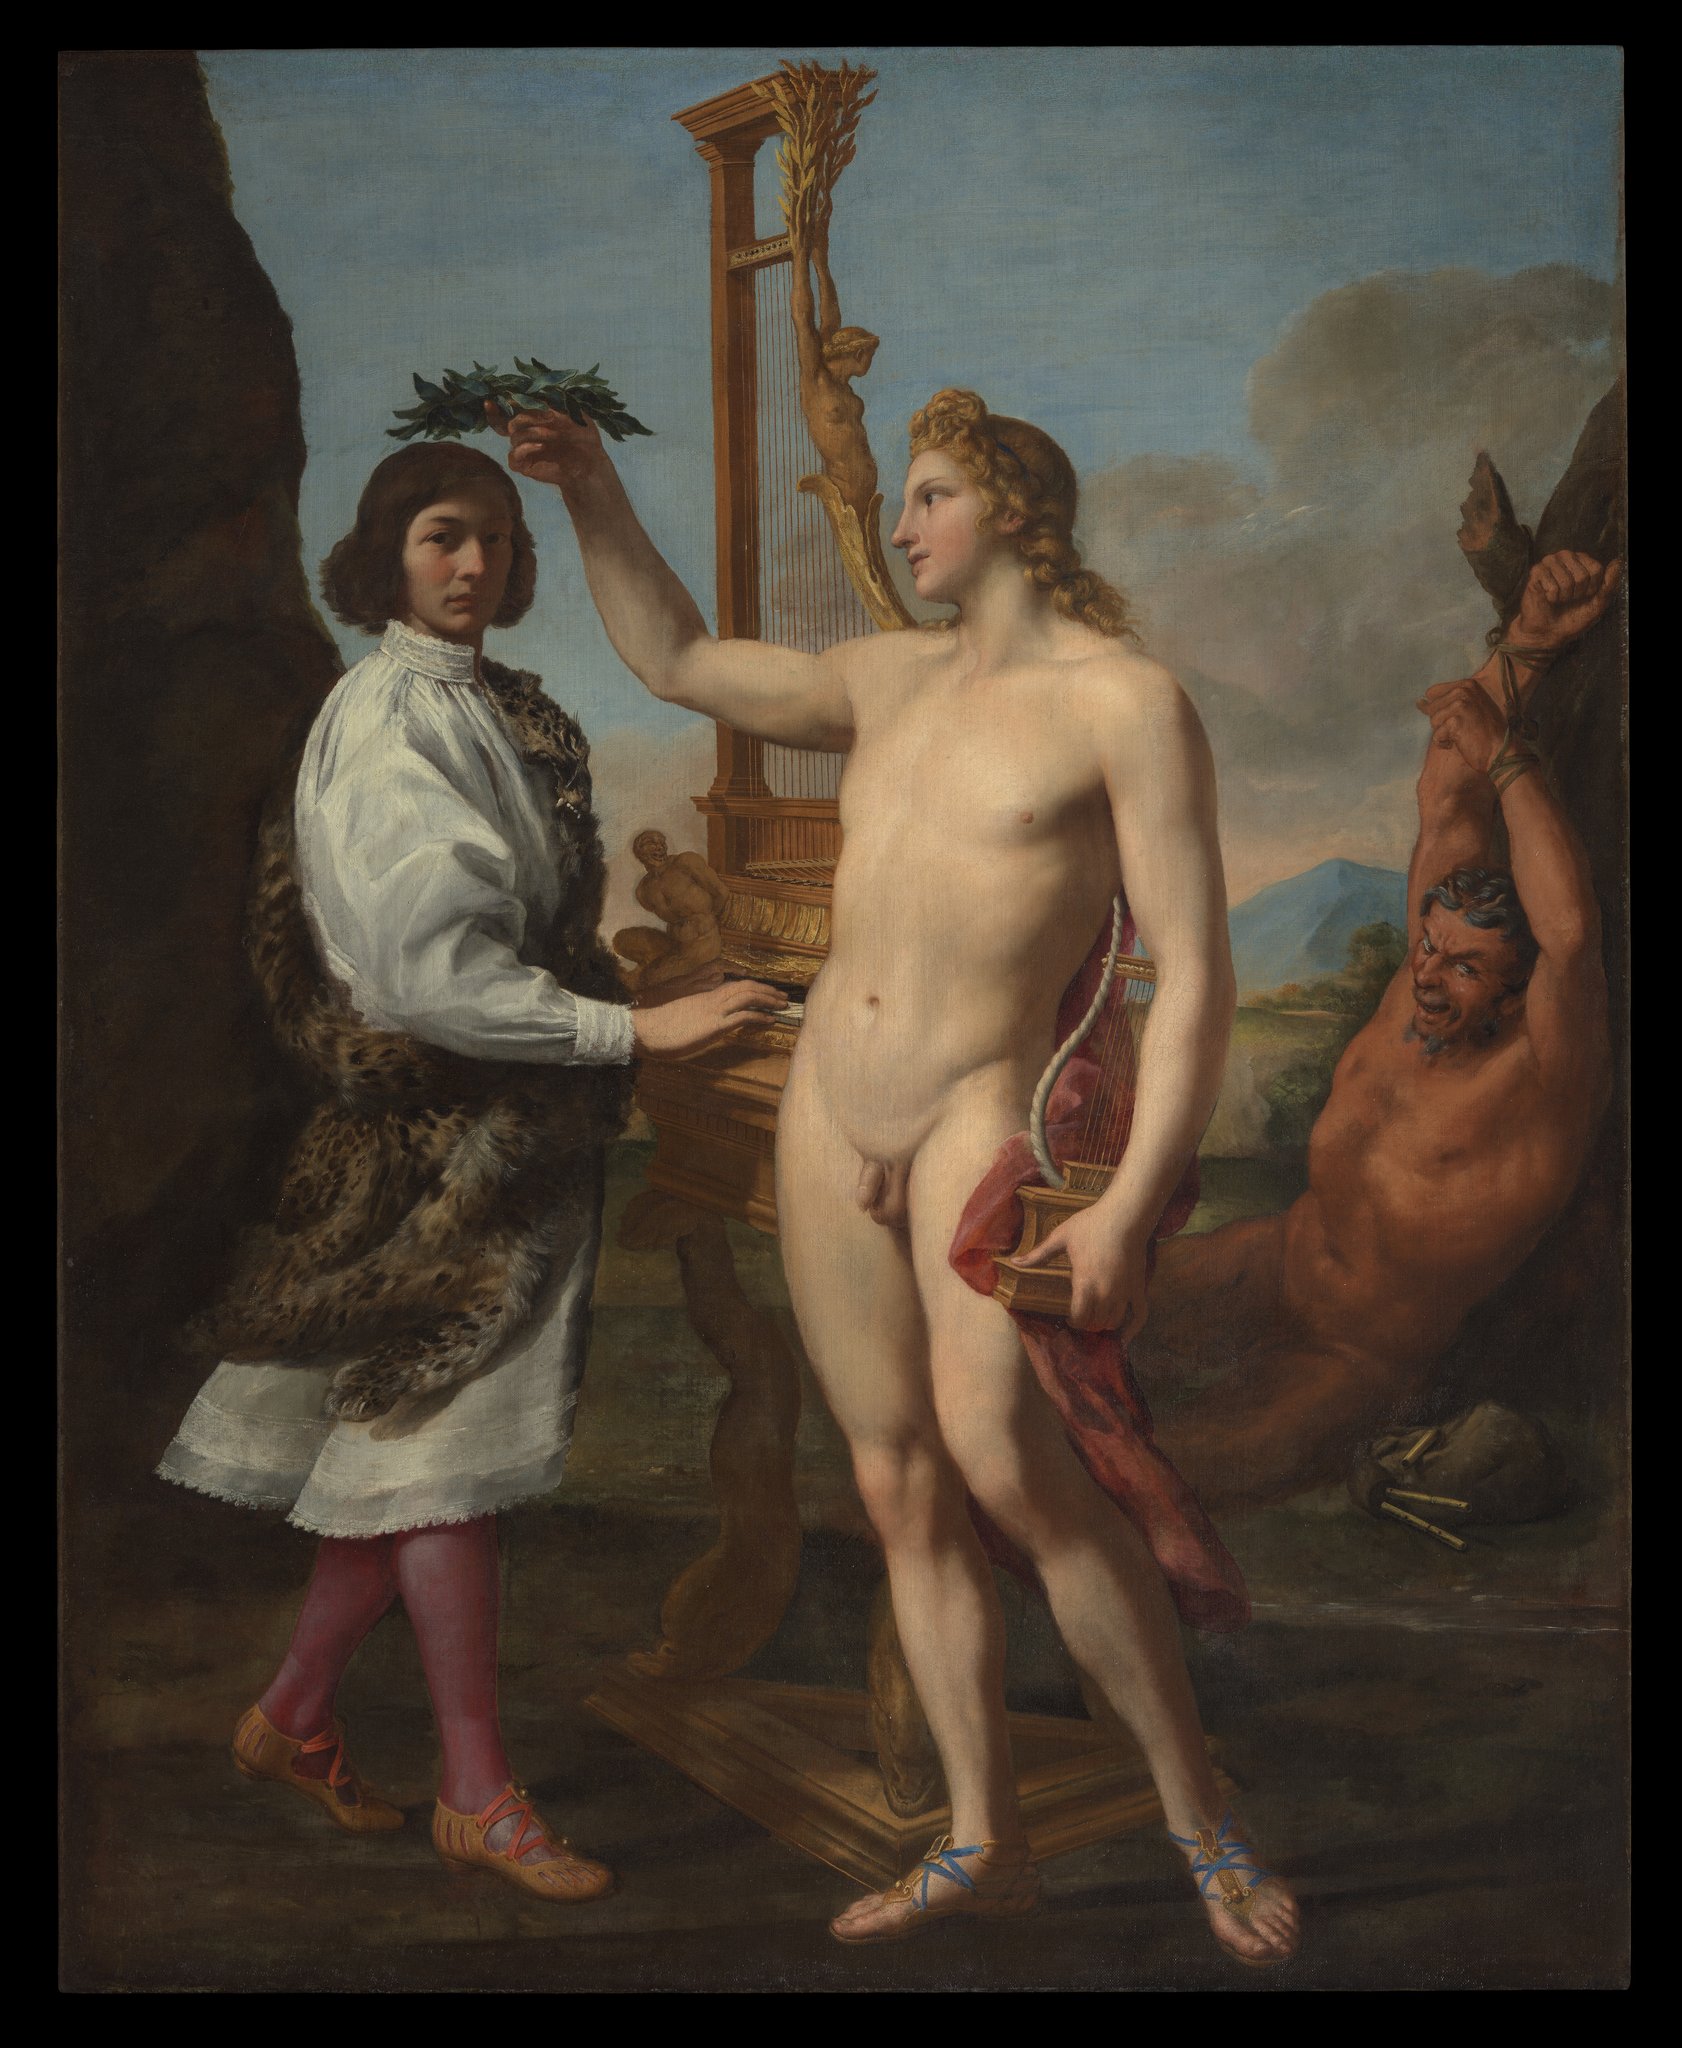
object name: painting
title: Marcantonio Pasqualini (1614–1691) Crowned by Apollo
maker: andrea sacchi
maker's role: artist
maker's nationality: italian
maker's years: 1599-1661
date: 1641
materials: canvas, oil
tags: men,harpsichords,apollo,satyrs